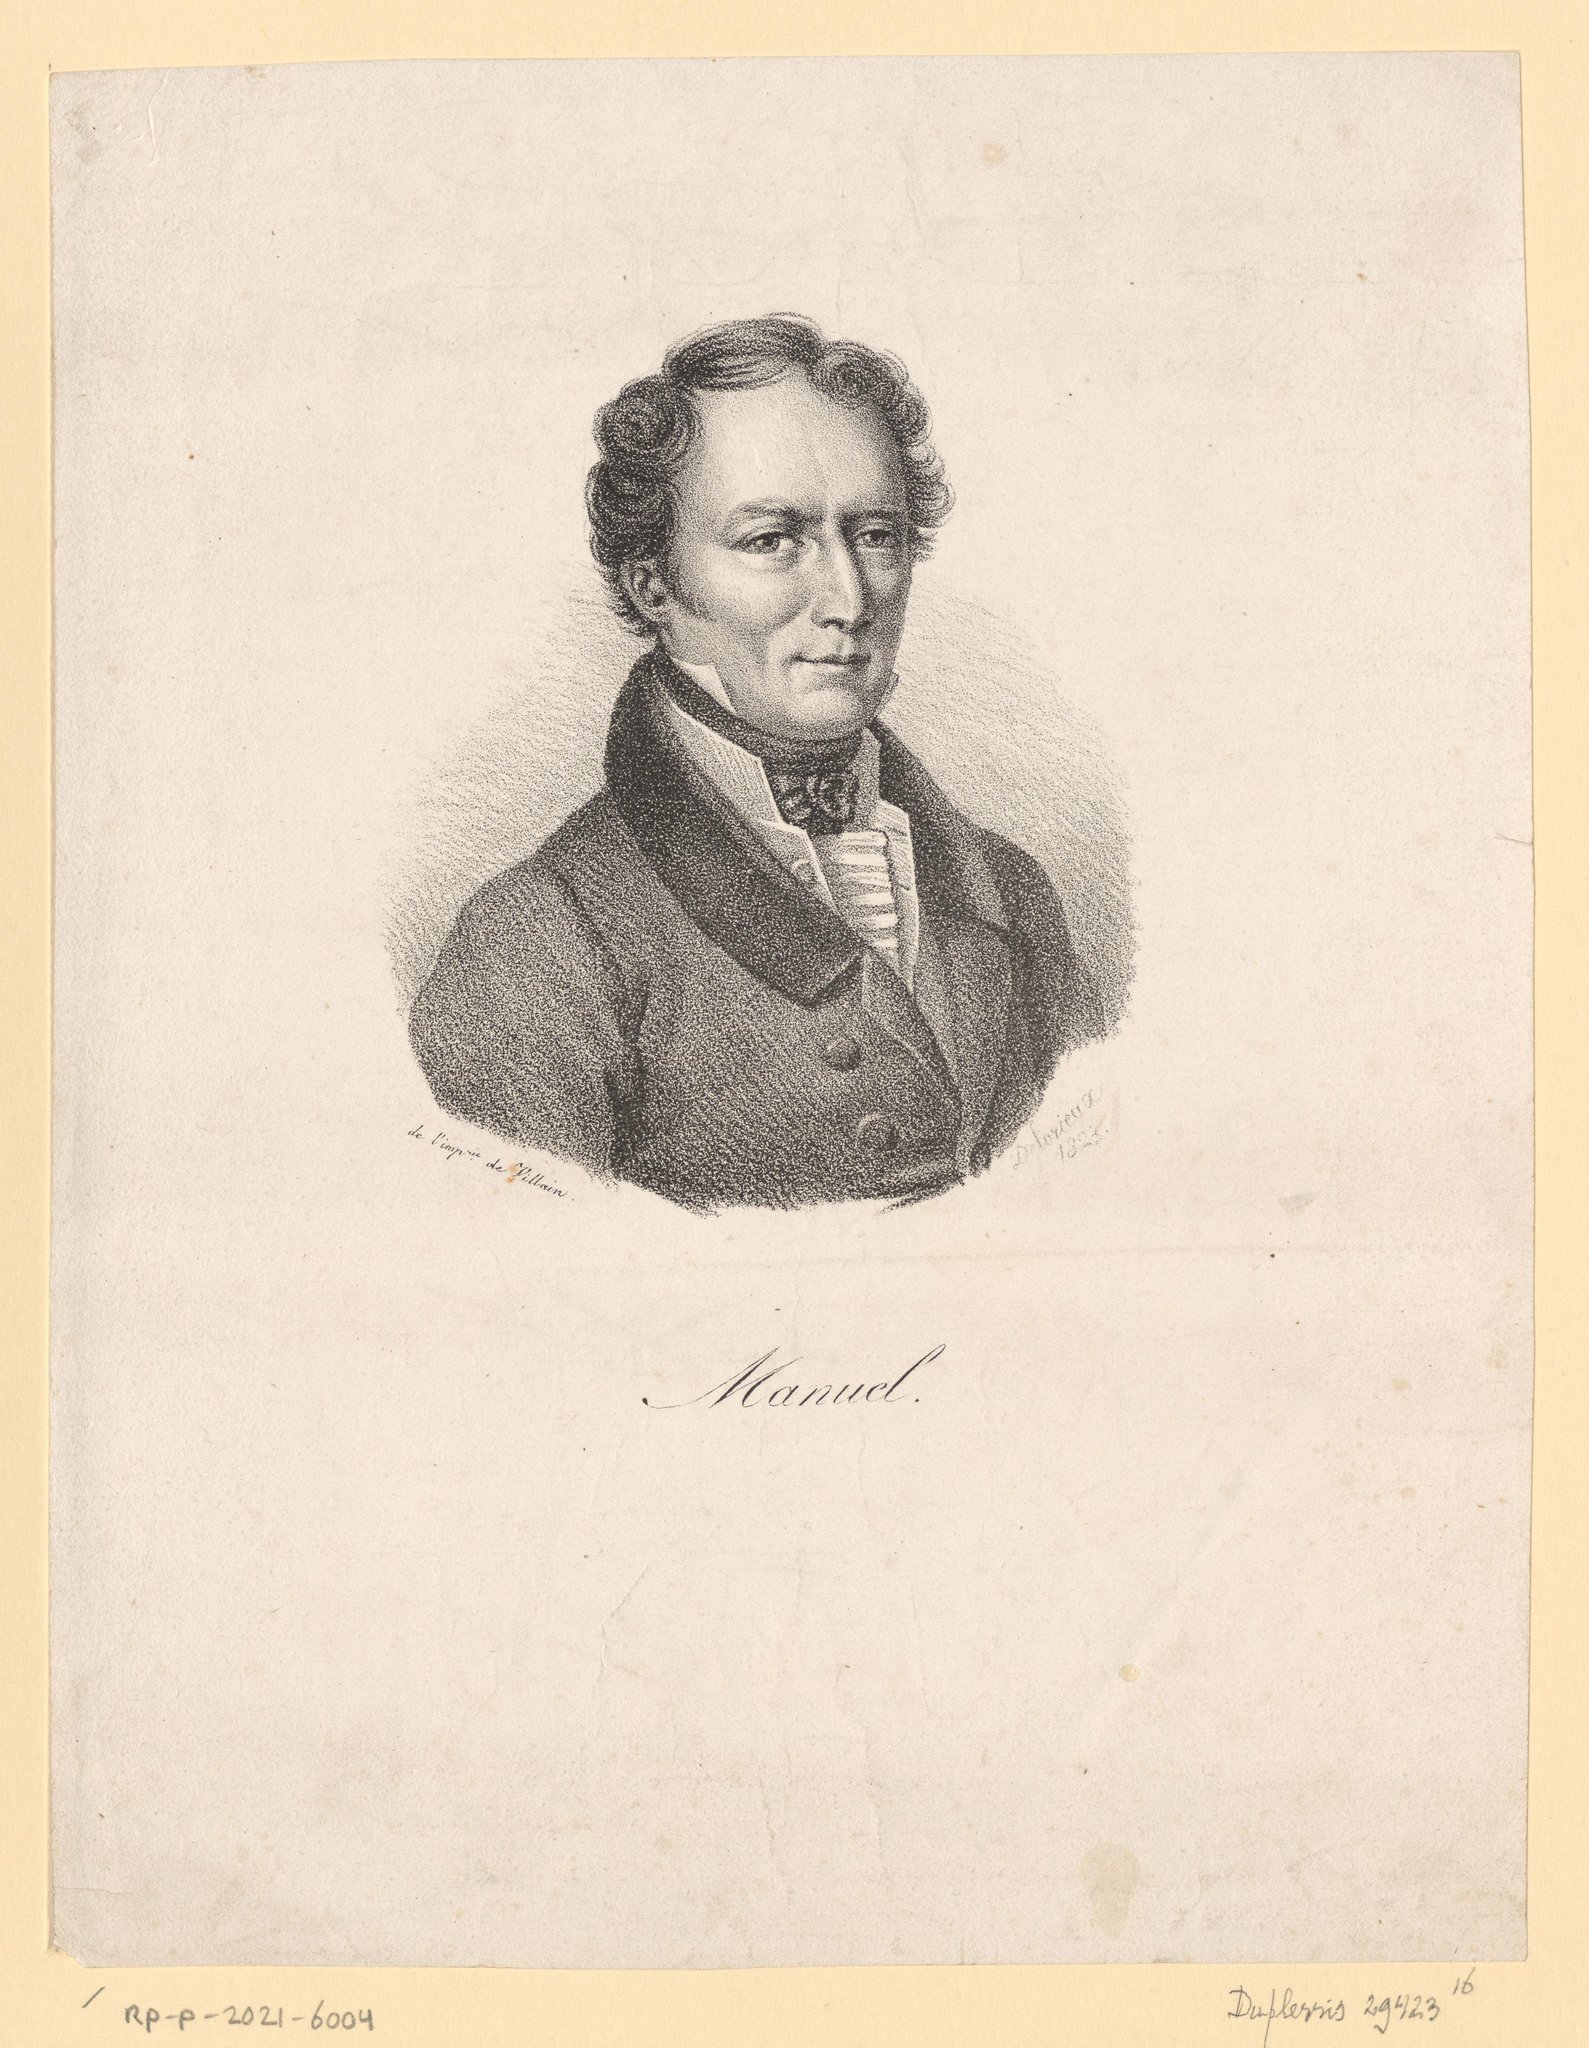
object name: print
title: Portret van Jacques-Antoine Manuel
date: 1823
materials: paper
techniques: lithograph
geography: paris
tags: politician, historical persons, politician, e.g. party leader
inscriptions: date